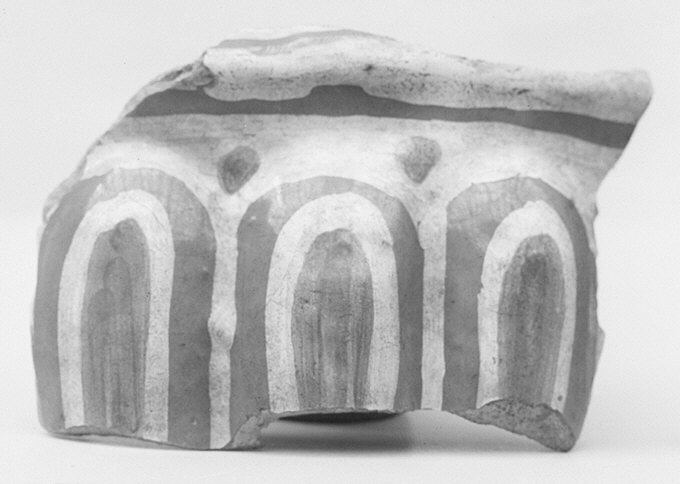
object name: fragment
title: Fragment (part of a set)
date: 1601-1700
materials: faience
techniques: glazing